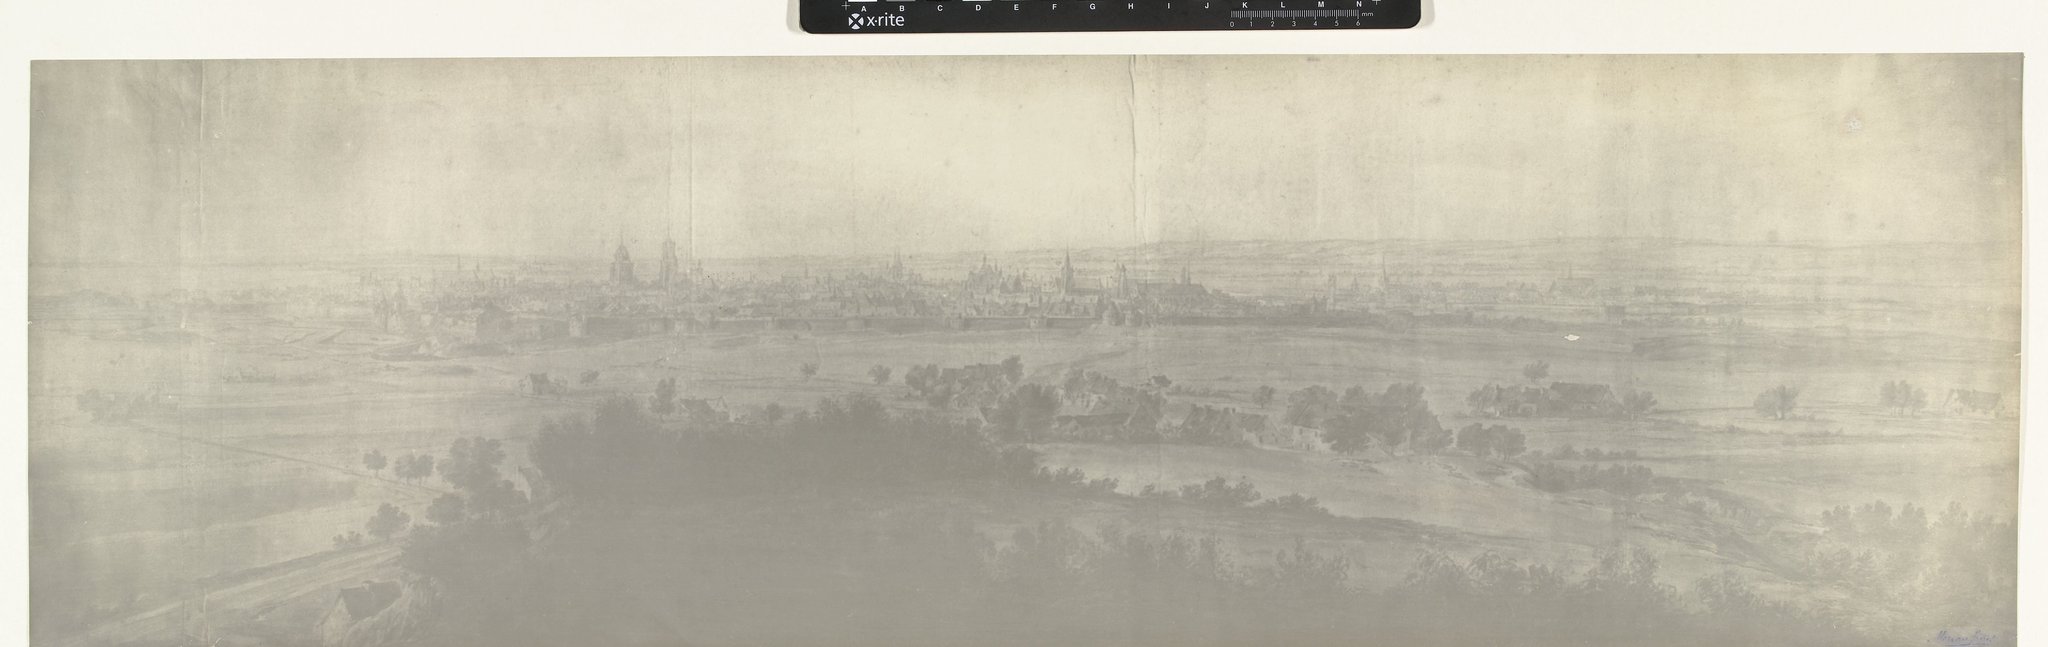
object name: photograph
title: Foto's van tekeningen van de Franse inval in de Nederlanden in 1672 door Adam Frans van der Meulen bewaard in de Manufacture des Gobelins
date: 1900-1903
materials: paper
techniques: gelatin silver print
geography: france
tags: lodewijk xiv (koning van frankrijk), prospect of city, town panorama, silhouette of city, maastricht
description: Niet in Frederik Muller; door het RPK toegevoegd nummer. Onderdeel van een groep van ca. 50 foto's van tekeningen van de Franse inval in de Nederlanden in 1672 door Adam Frans van der Meulen, bewaard in de Manufacture Nationale des Gobelins te Parijs.